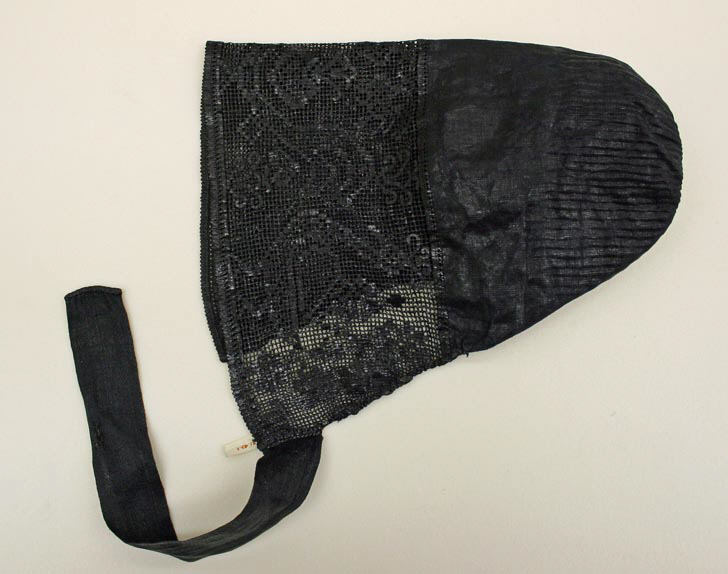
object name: cap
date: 1701-1800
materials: cotton